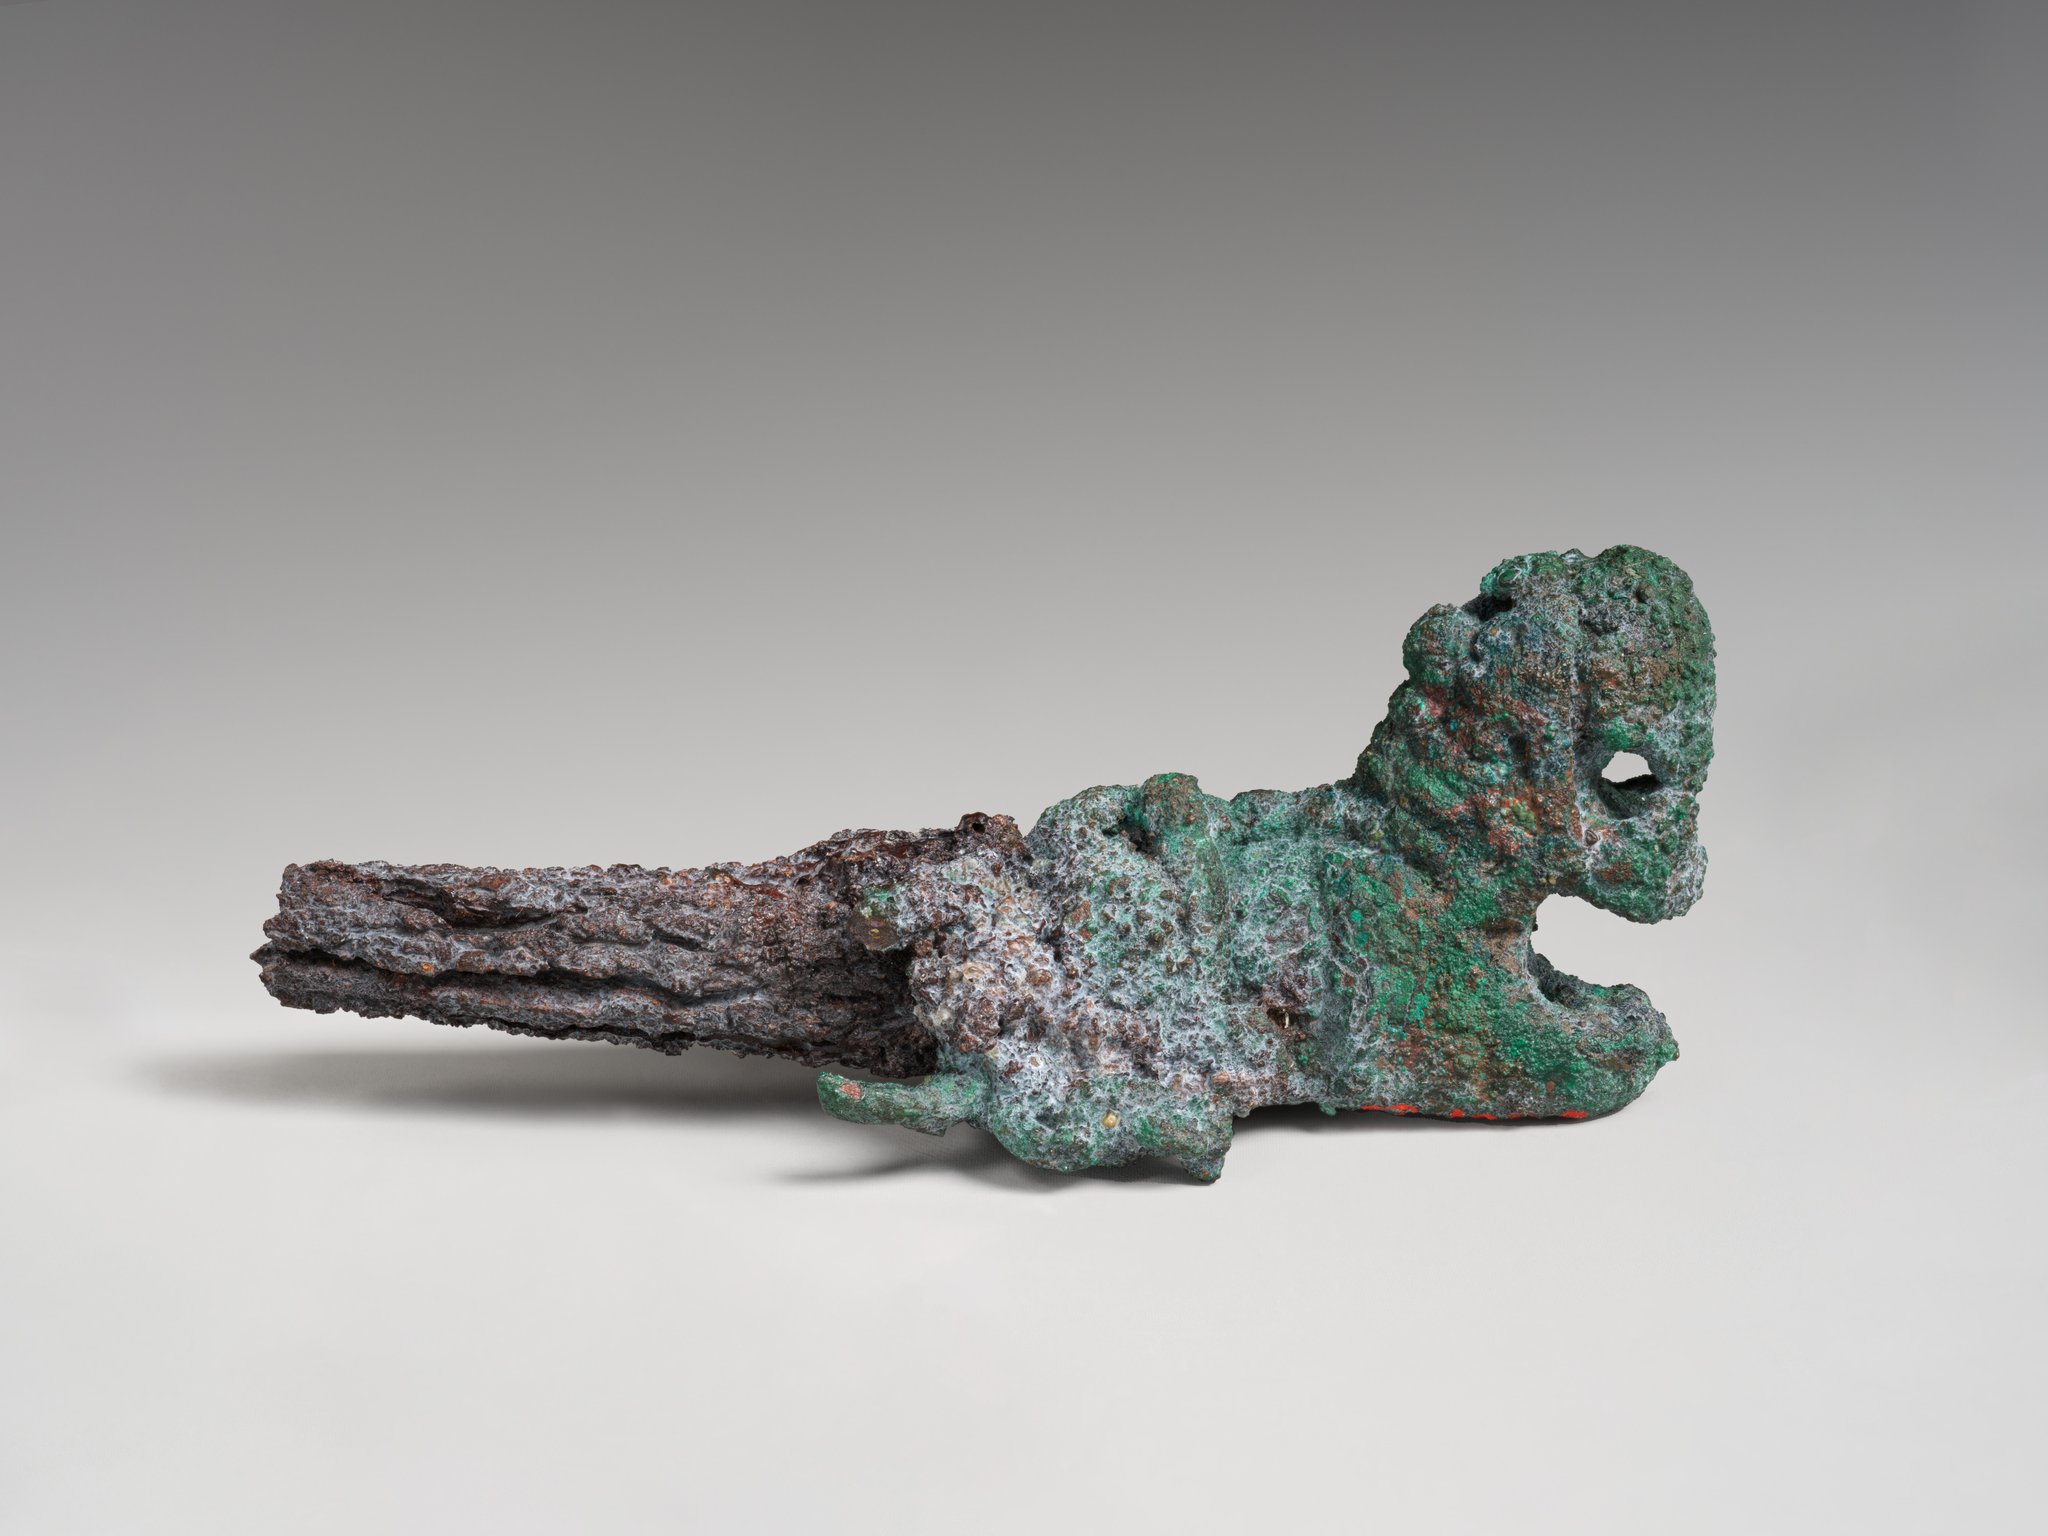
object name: pin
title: Lion pin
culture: iranian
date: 900-801 BCE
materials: bronze, iron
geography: iran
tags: lions